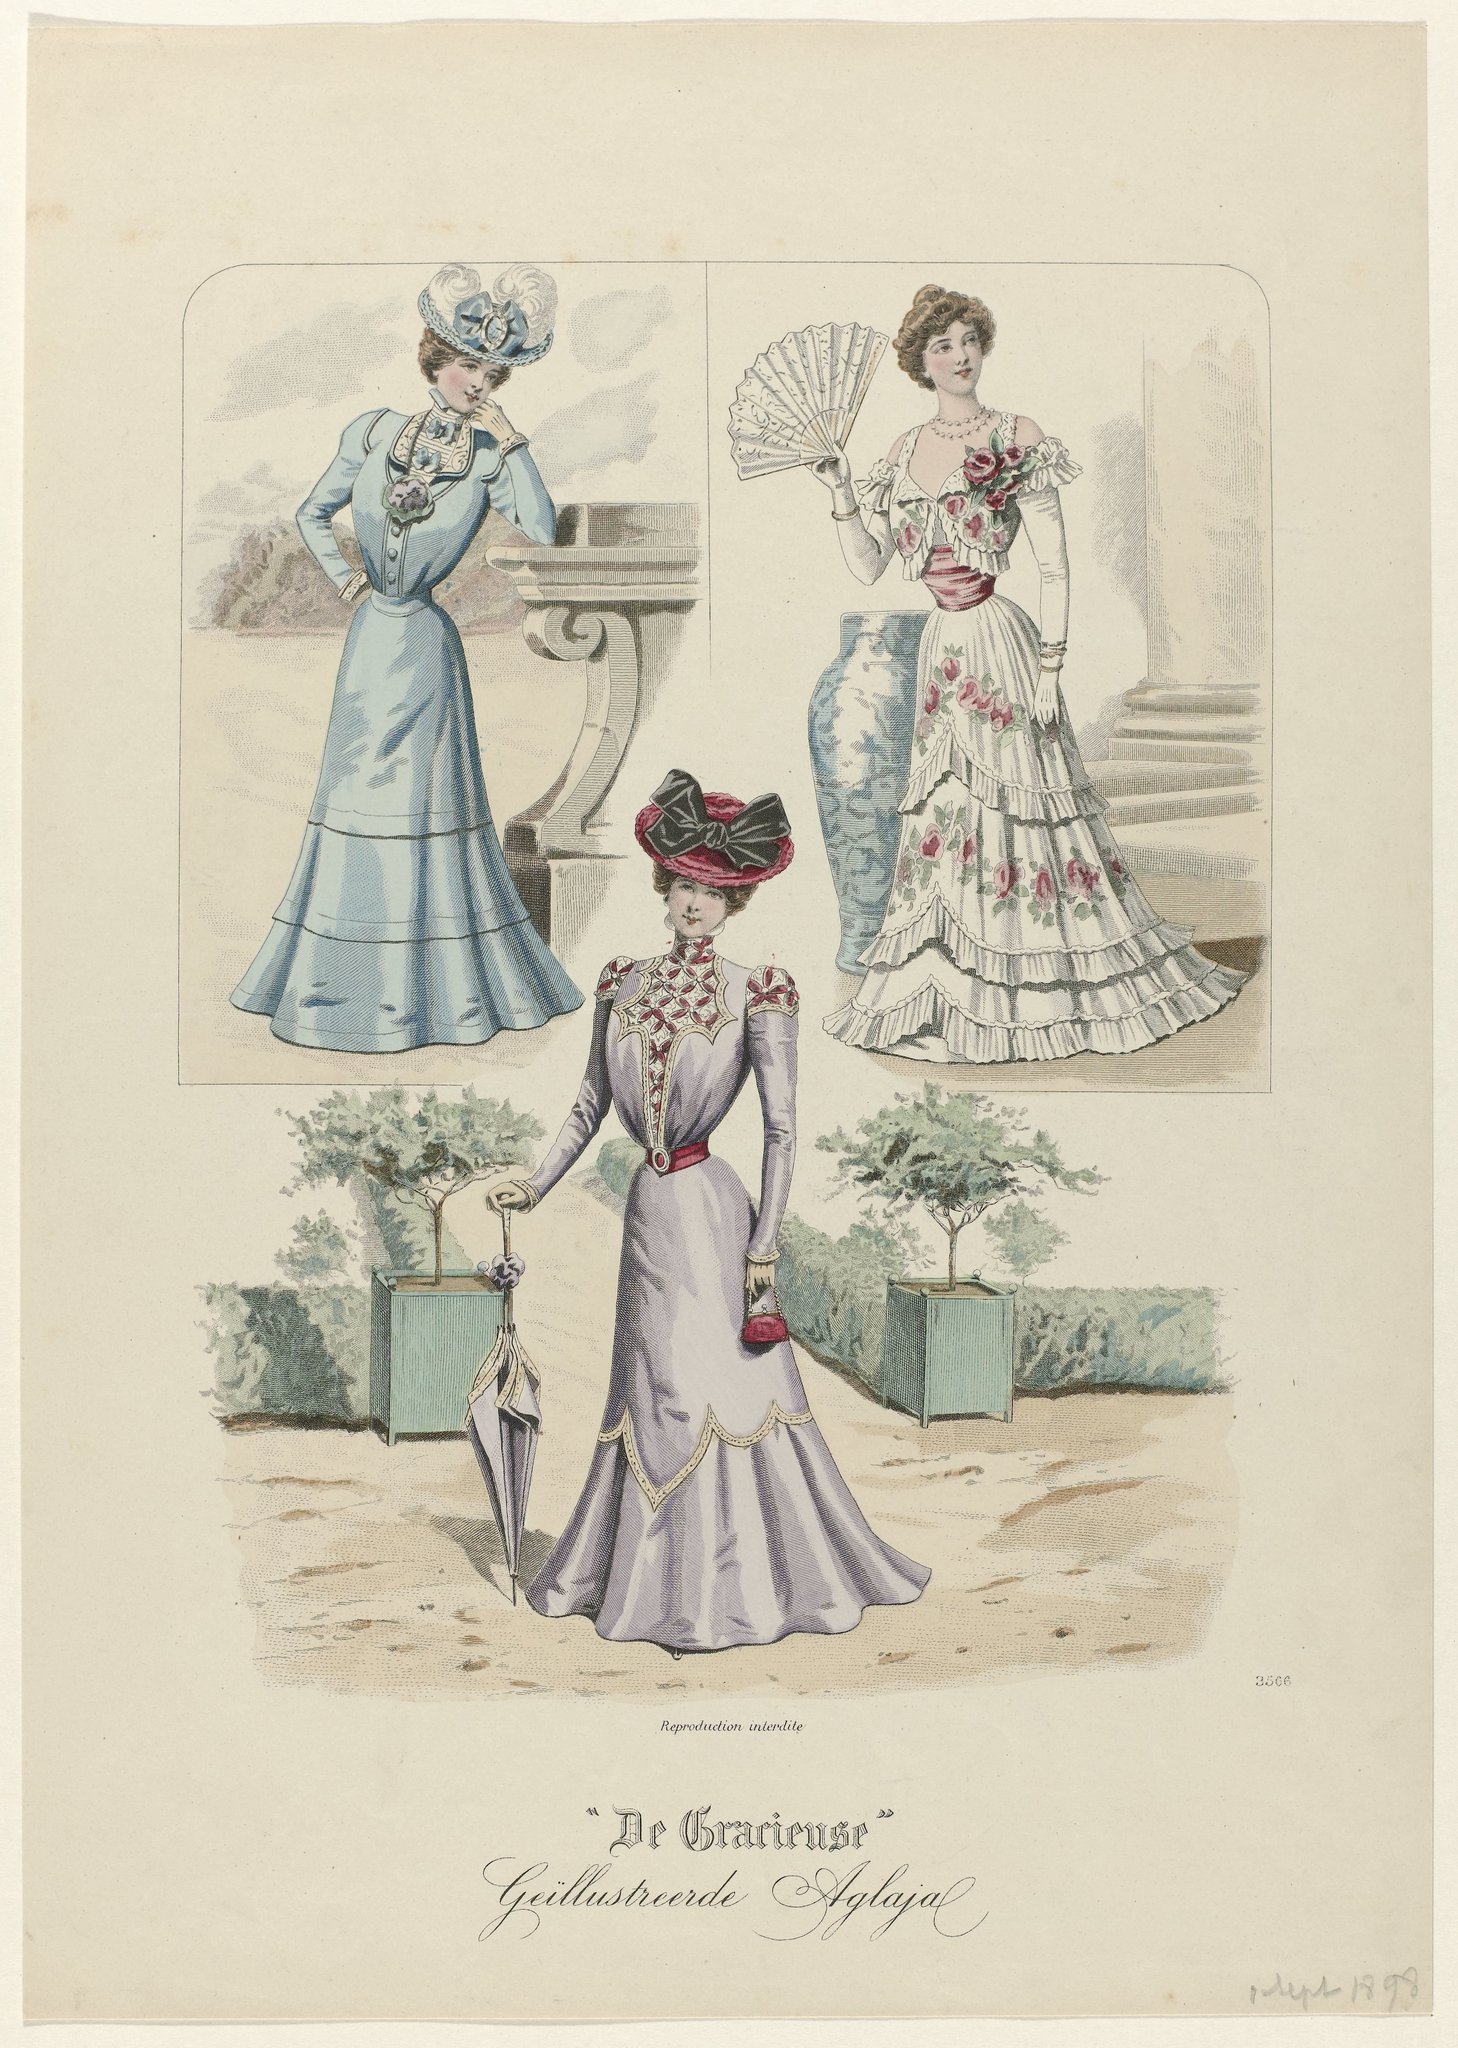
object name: fashion print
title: De Gracieuse, Geïllustreerde Aglaja, september 1898, No. 3566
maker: Anonymous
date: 1898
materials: paper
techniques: engraving, hand coloring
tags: corsage (+ women's clothes), dress, gown: evening dress (+ women's clothes), walking-stick, staff, cane (+ women's clothes), bag (handbag) (+ women's clothes), fashion plates, head-gear: hat (+ women's clothes)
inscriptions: title: ‘"De Gracieuse" / Geïllustreerde Aglaja.’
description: Drie modellen van japonnen, waaronder één avondjapon. Prent uit het modetijdschrift De Gracieuse (1865-1936).